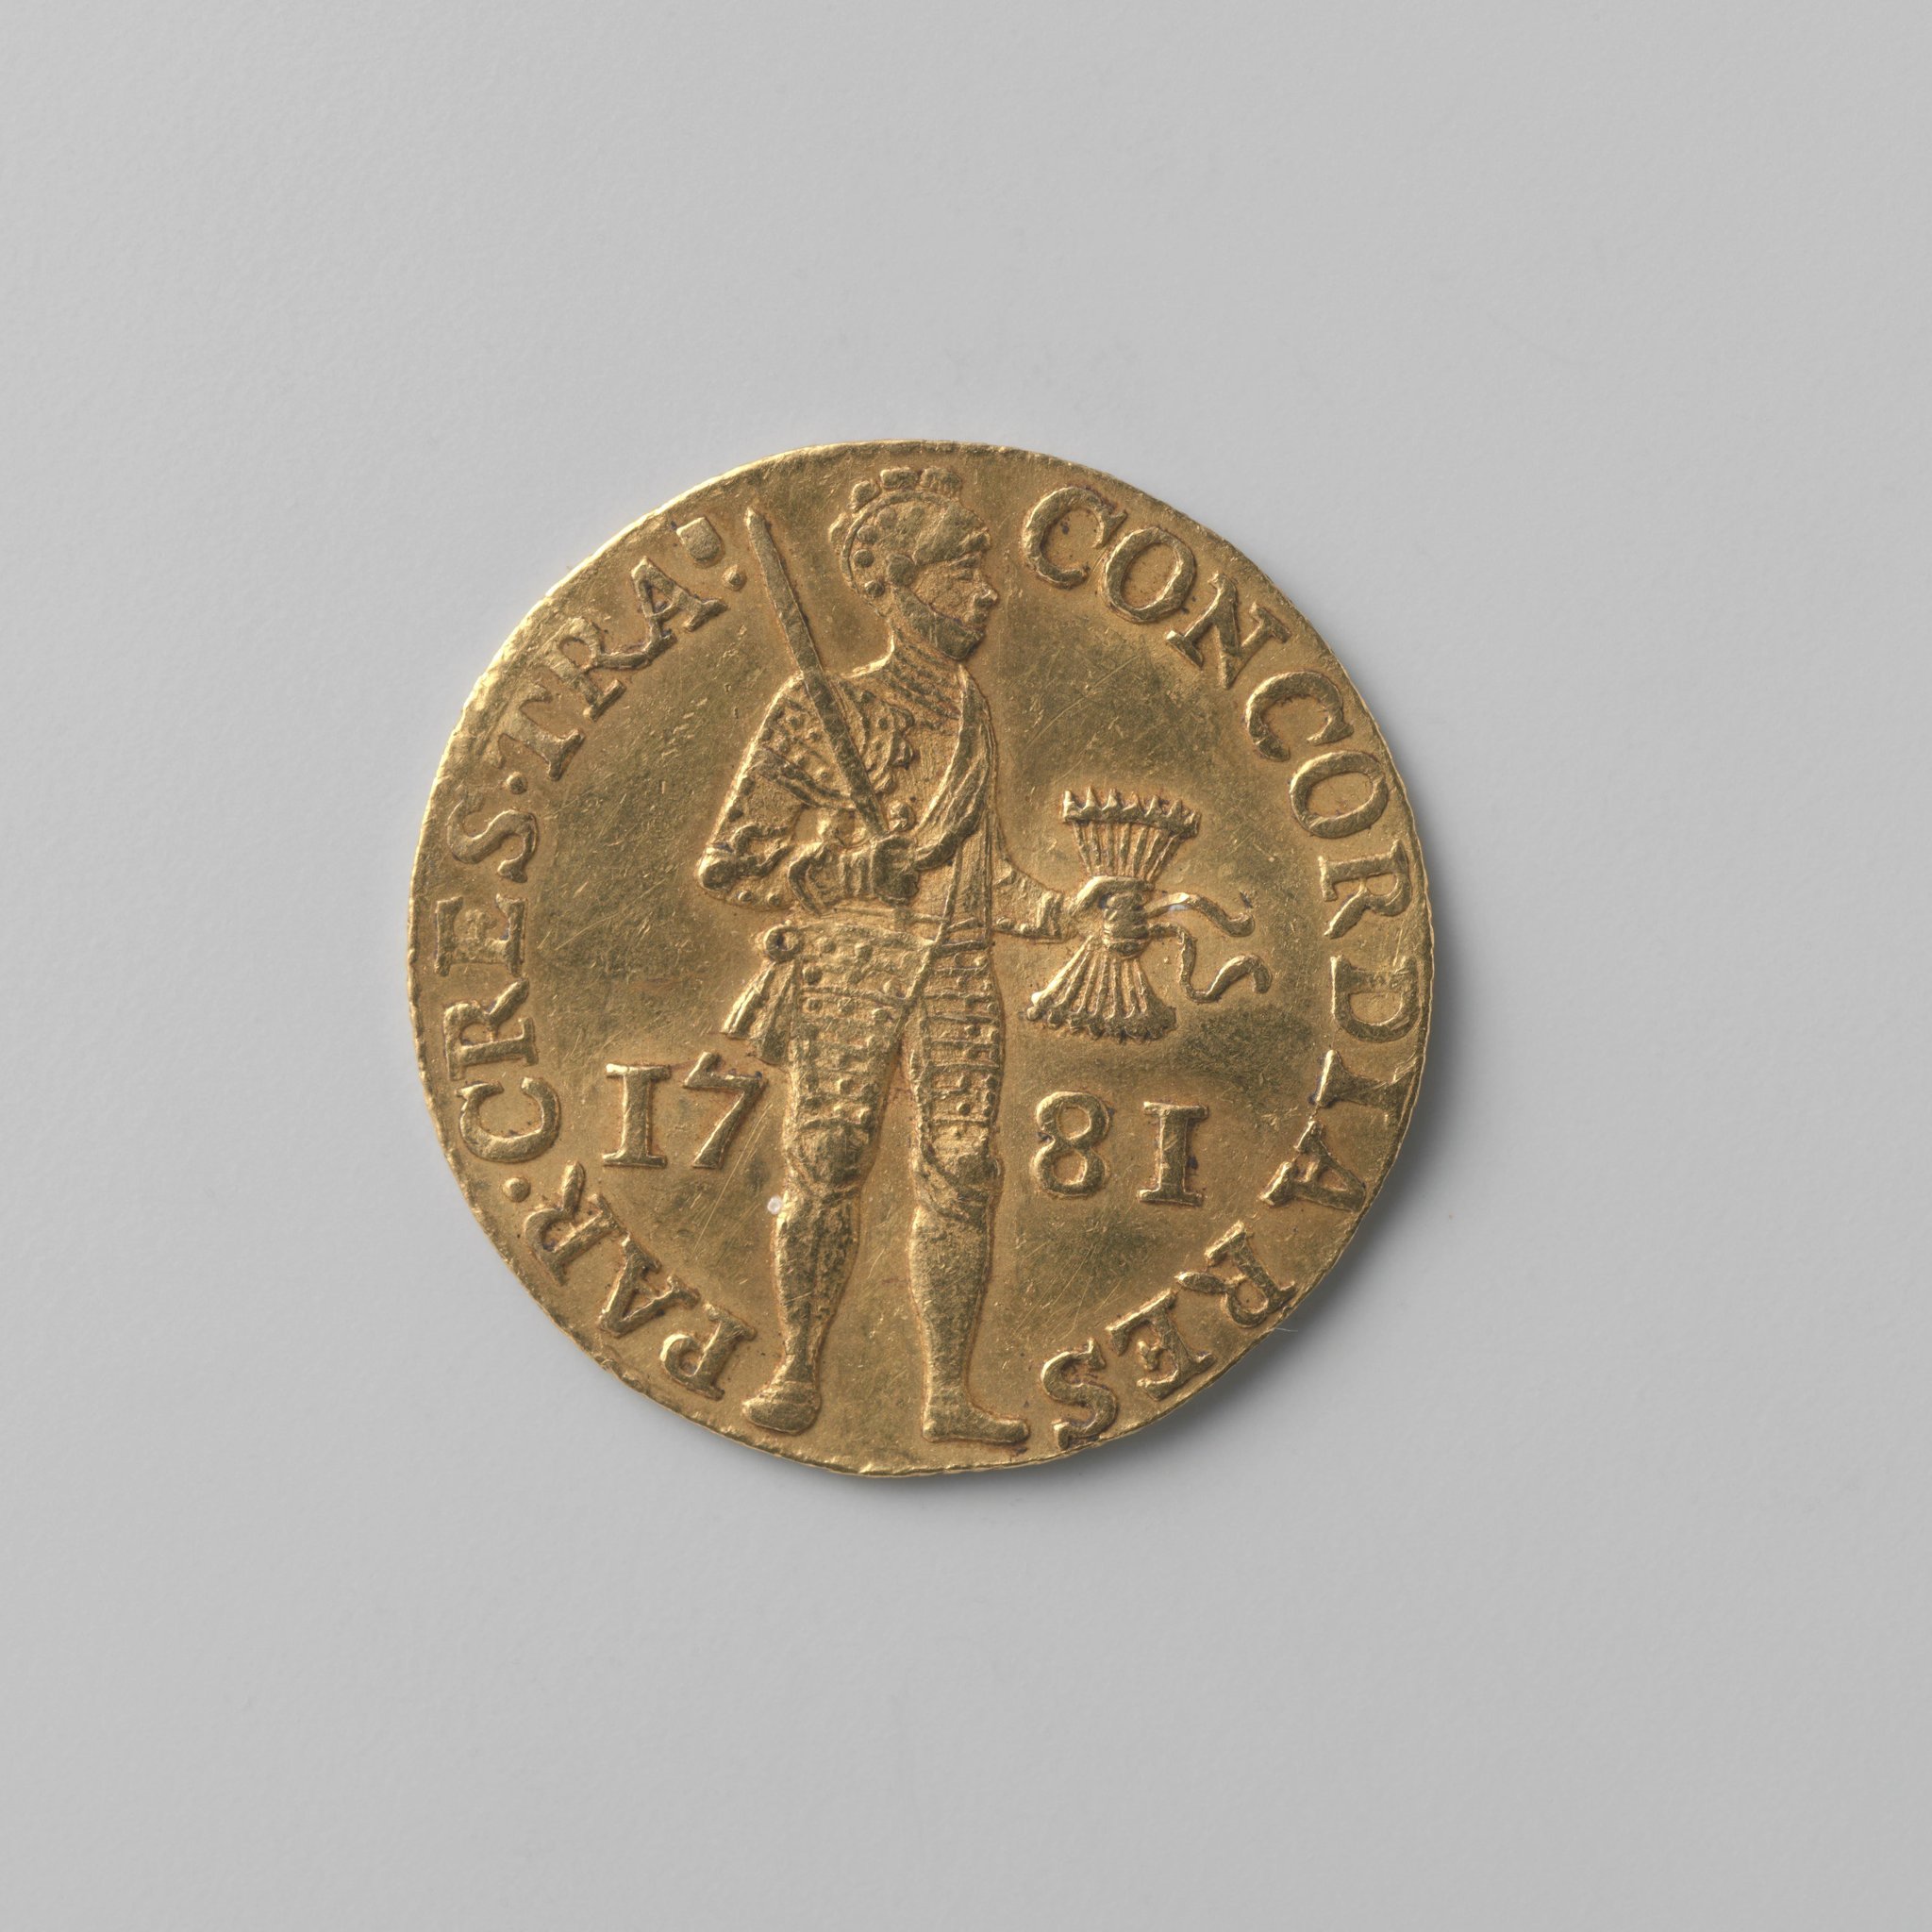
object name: ducat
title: Utrechtse dukaat, 1781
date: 1781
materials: gold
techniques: striking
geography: utrecht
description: Gouden munt. Voorzijde: tussen jaartal staande ridder naar rechts. In rechterhand zwaard, in linkerhand pijlenbundel. Keerzijde: in versierd vierkant vijfregelig opschrift. Kabelrand.